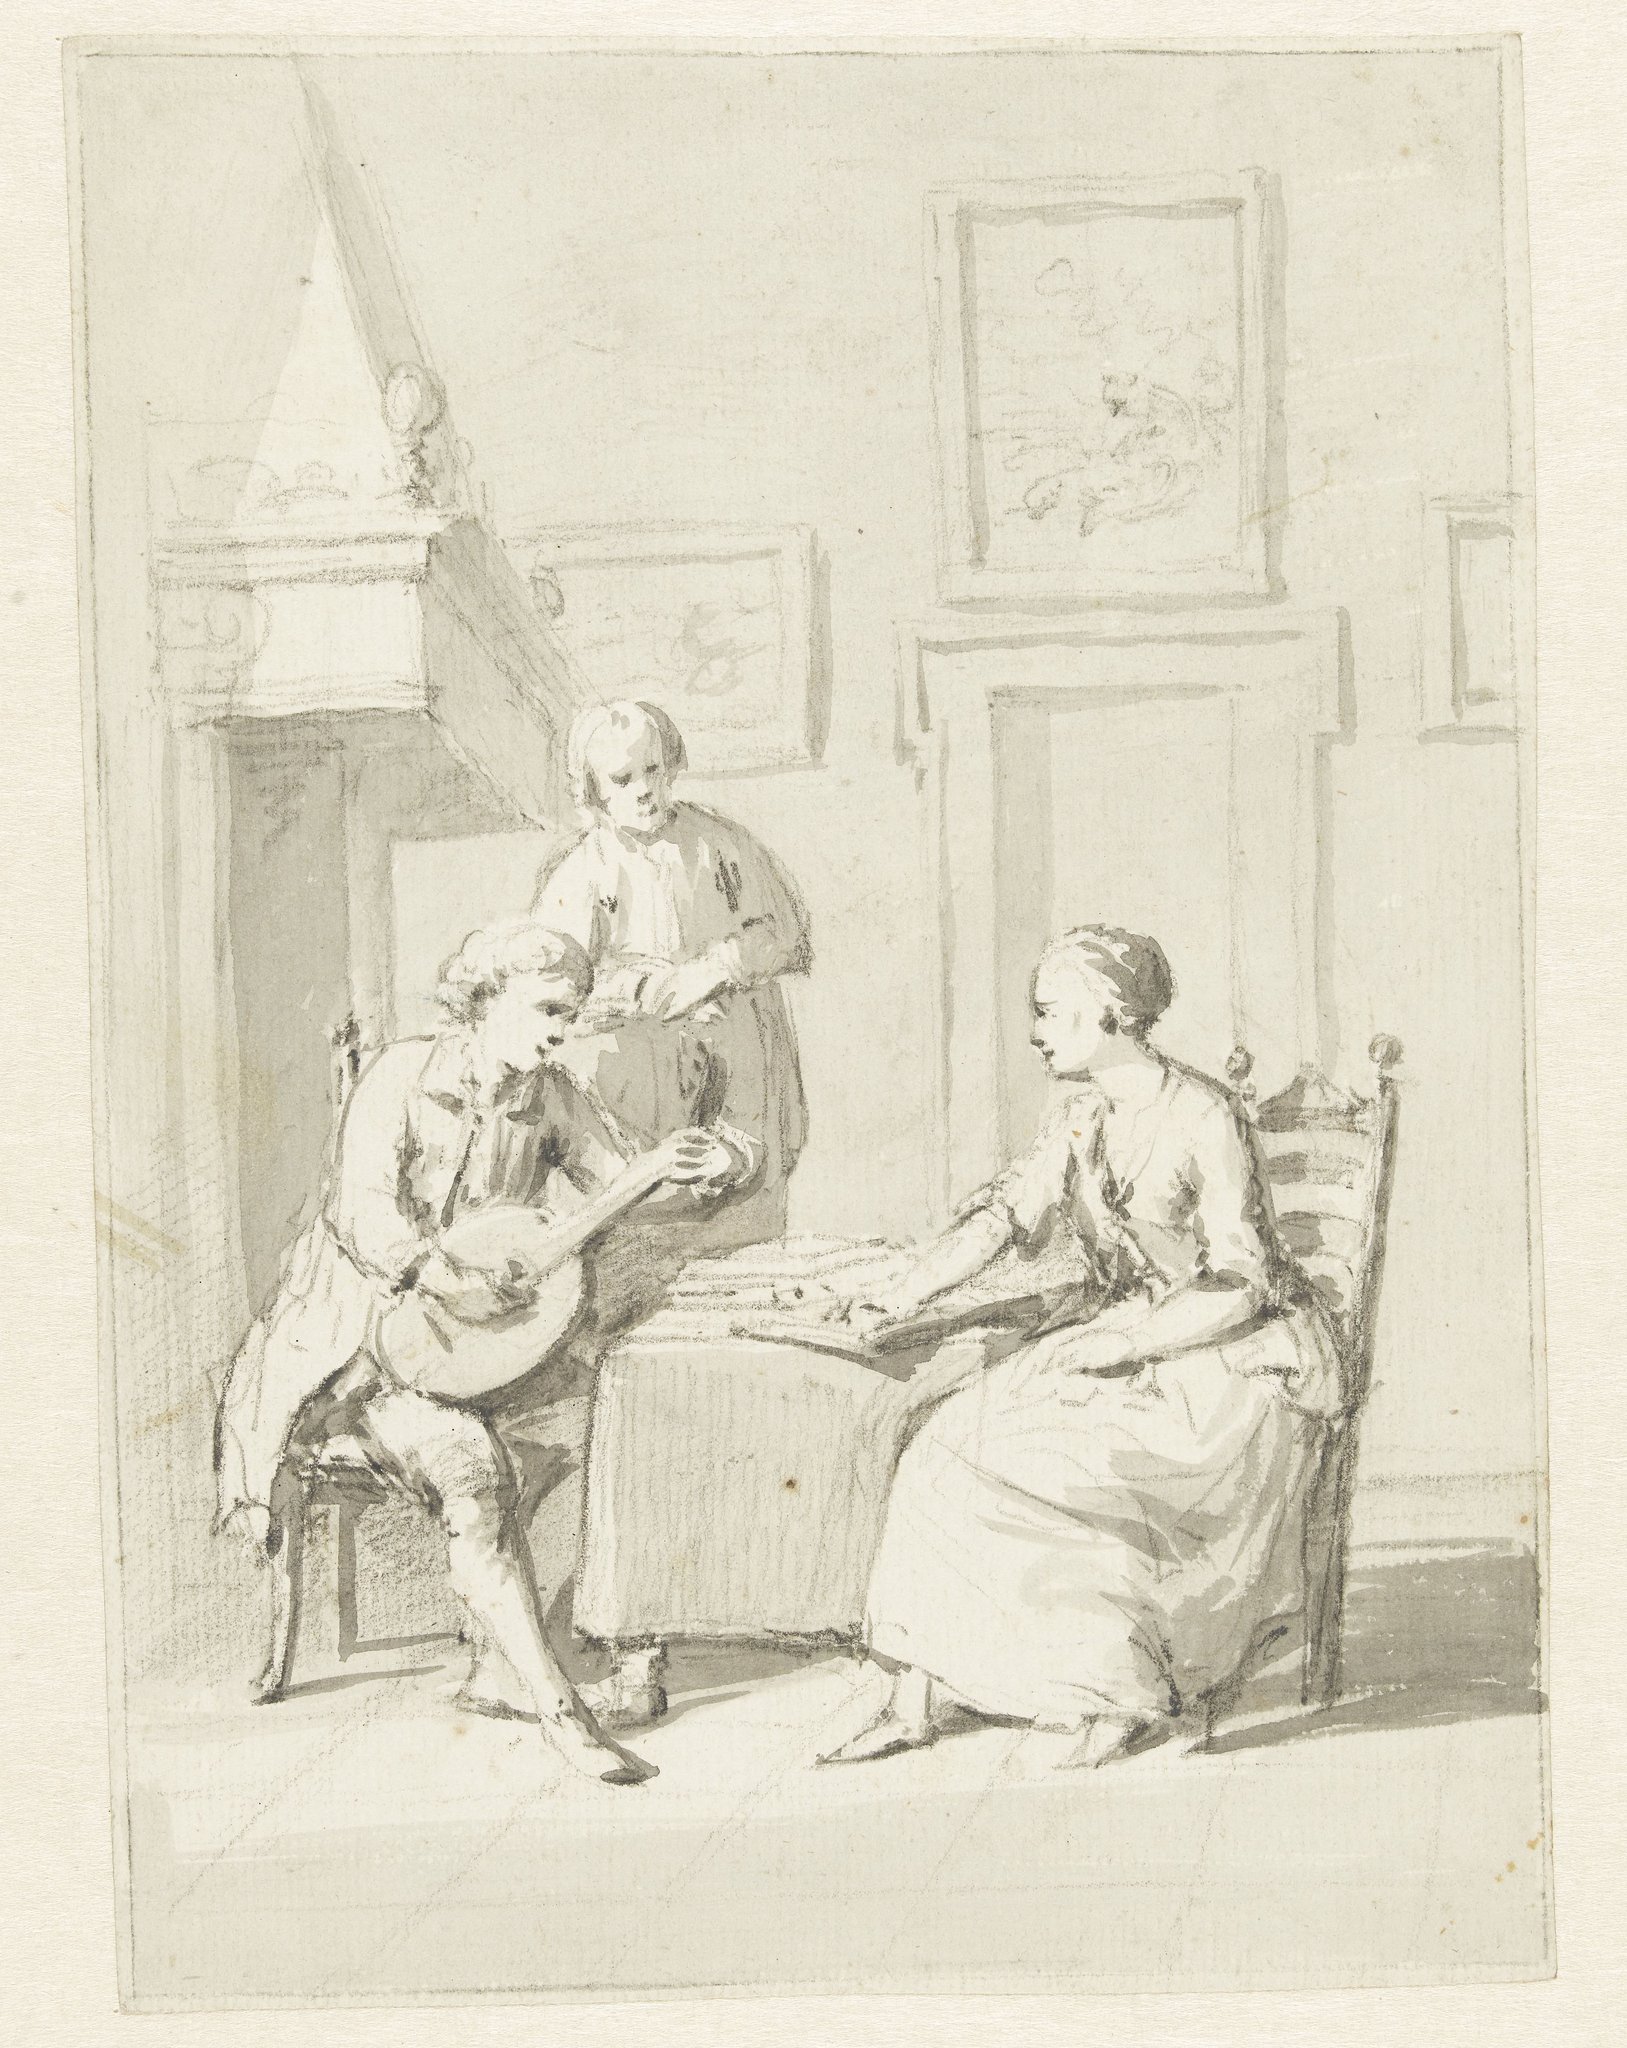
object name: drawing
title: Interieur met luitspeler, zittende vrouw en staande man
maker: pieter bartholomeusz. barbiers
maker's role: draughtsman, print maker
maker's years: 1772-1837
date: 1782-1837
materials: chalk, paper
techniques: brush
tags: one person playing string instrument (plucked), lute, and special forms of lute, e.g.: theorbo